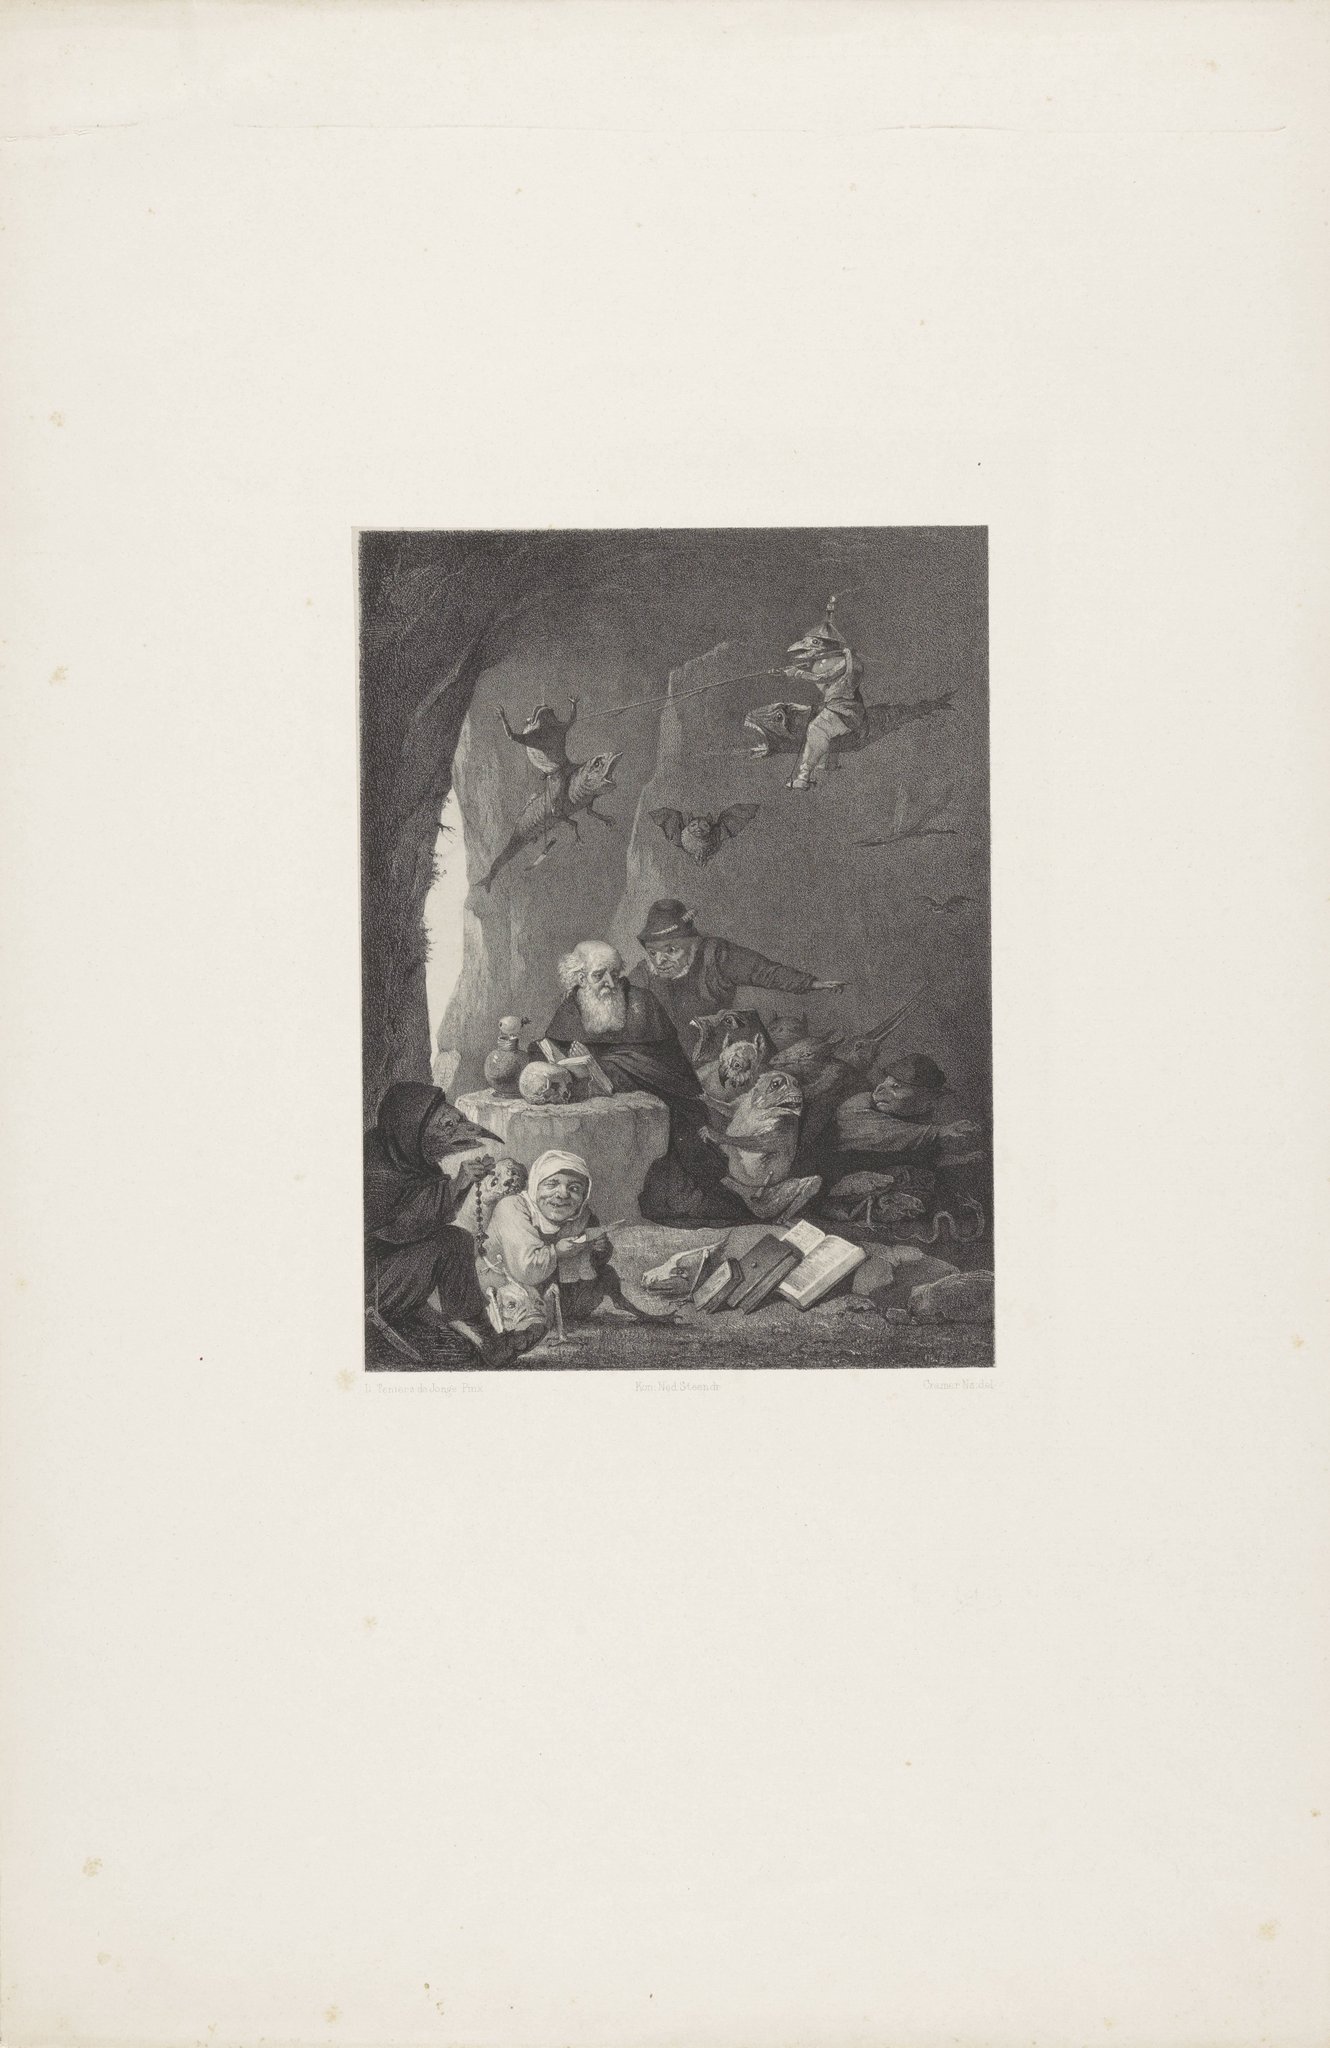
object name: print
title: Verzoeking van de heilige Antonius de Heremiet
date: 1867-1874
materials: paper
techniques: lithograph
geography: belgium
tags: temptations of st. antony abbot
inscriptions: collector's mark: Lugt 2228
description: In een grot bidt de geknielde Antonius met gevouwen handen voor een openstaand boek dat rust op een schedel. De kluizenaar wordt omringd door allerlei duivels en monsters die hem proberen af te leiden. In de lucht houden een kikker en een vogel, gezeten op vliegende vissen, een steekspel. Links op de voorgrond een duivel in monnikskap met een rozenkrans.